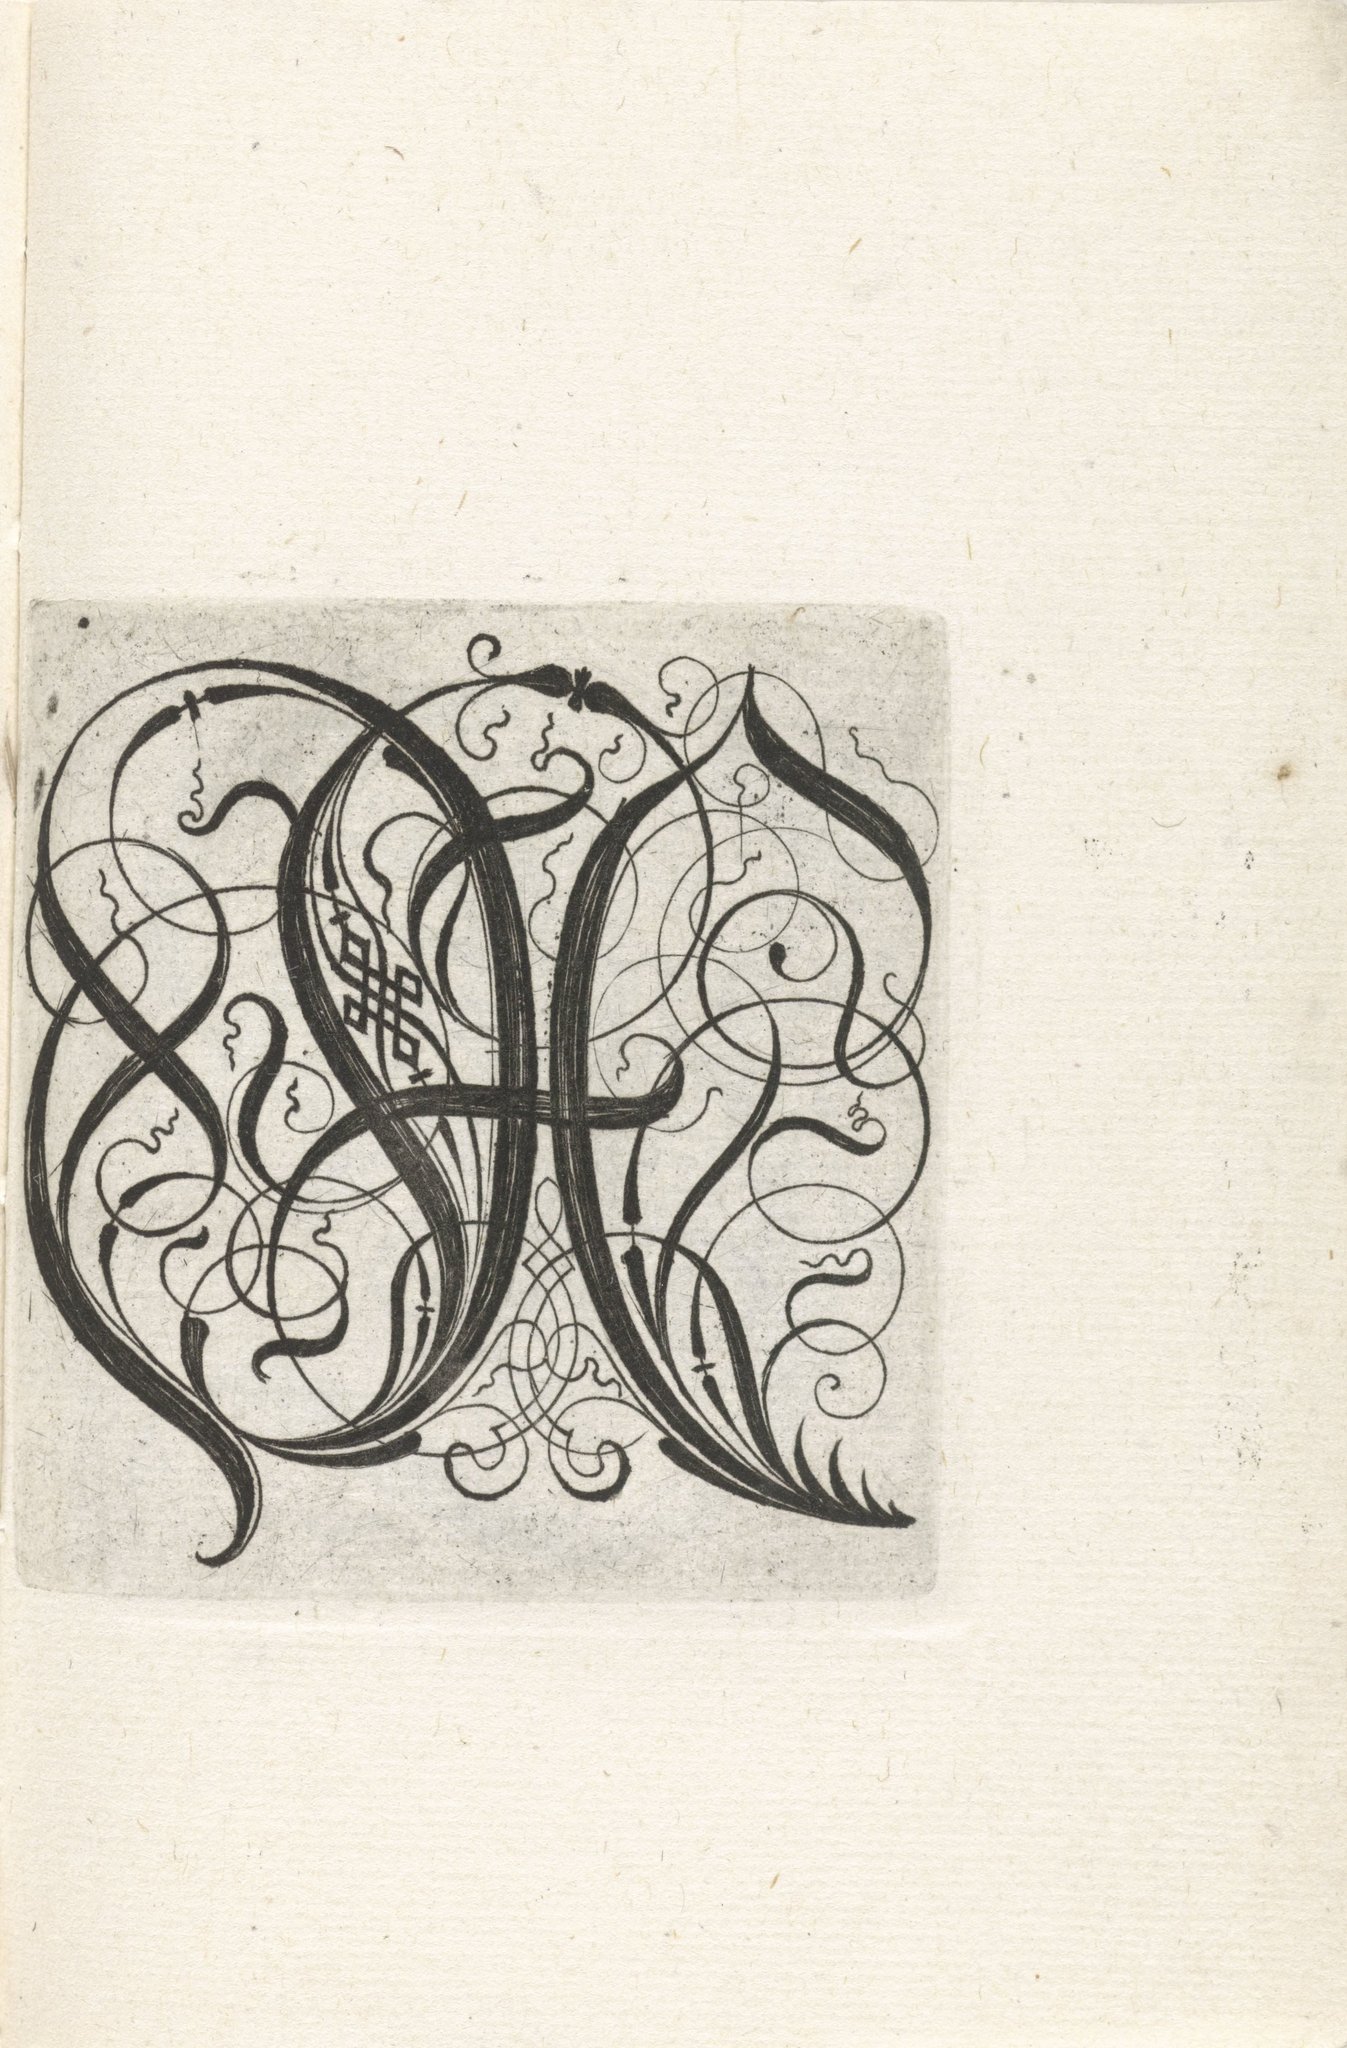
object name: print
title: Letter X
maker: Anonymous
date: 1600-1699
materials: paper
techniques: engraving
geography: netherlands